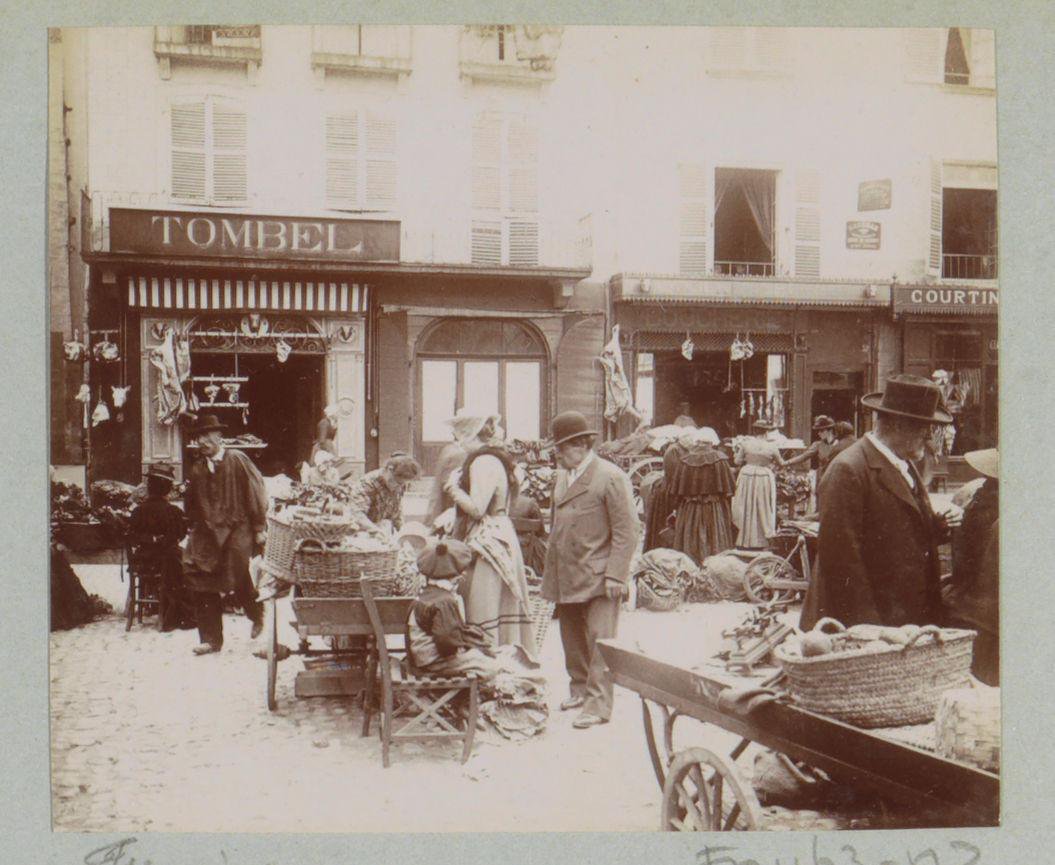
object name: photograph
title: Straatmarkt in Issoire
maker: delizy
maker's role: manufacturer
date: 1902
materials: paper, photographic support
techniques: gelatin silver print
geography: issoire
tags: market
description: Onderdeel van Fotoalbum van een Franse amateurfotograaf met opnames van uitstapjes in Frankrijk, Spanje, België, Luxemburg en Nederland, de eerste automobielen en autoraces.